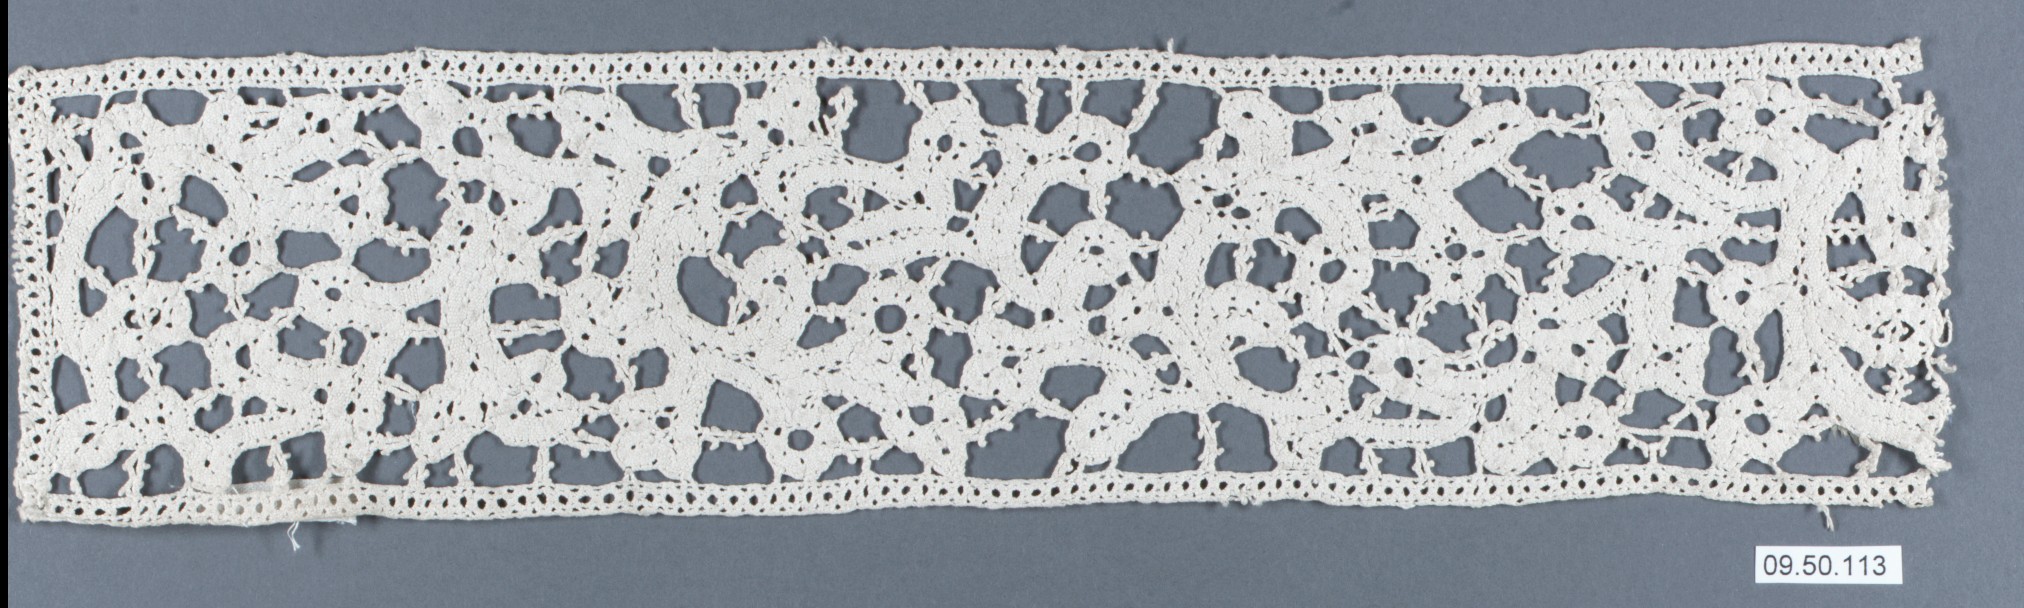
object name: strip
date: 1701-1800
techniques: lace